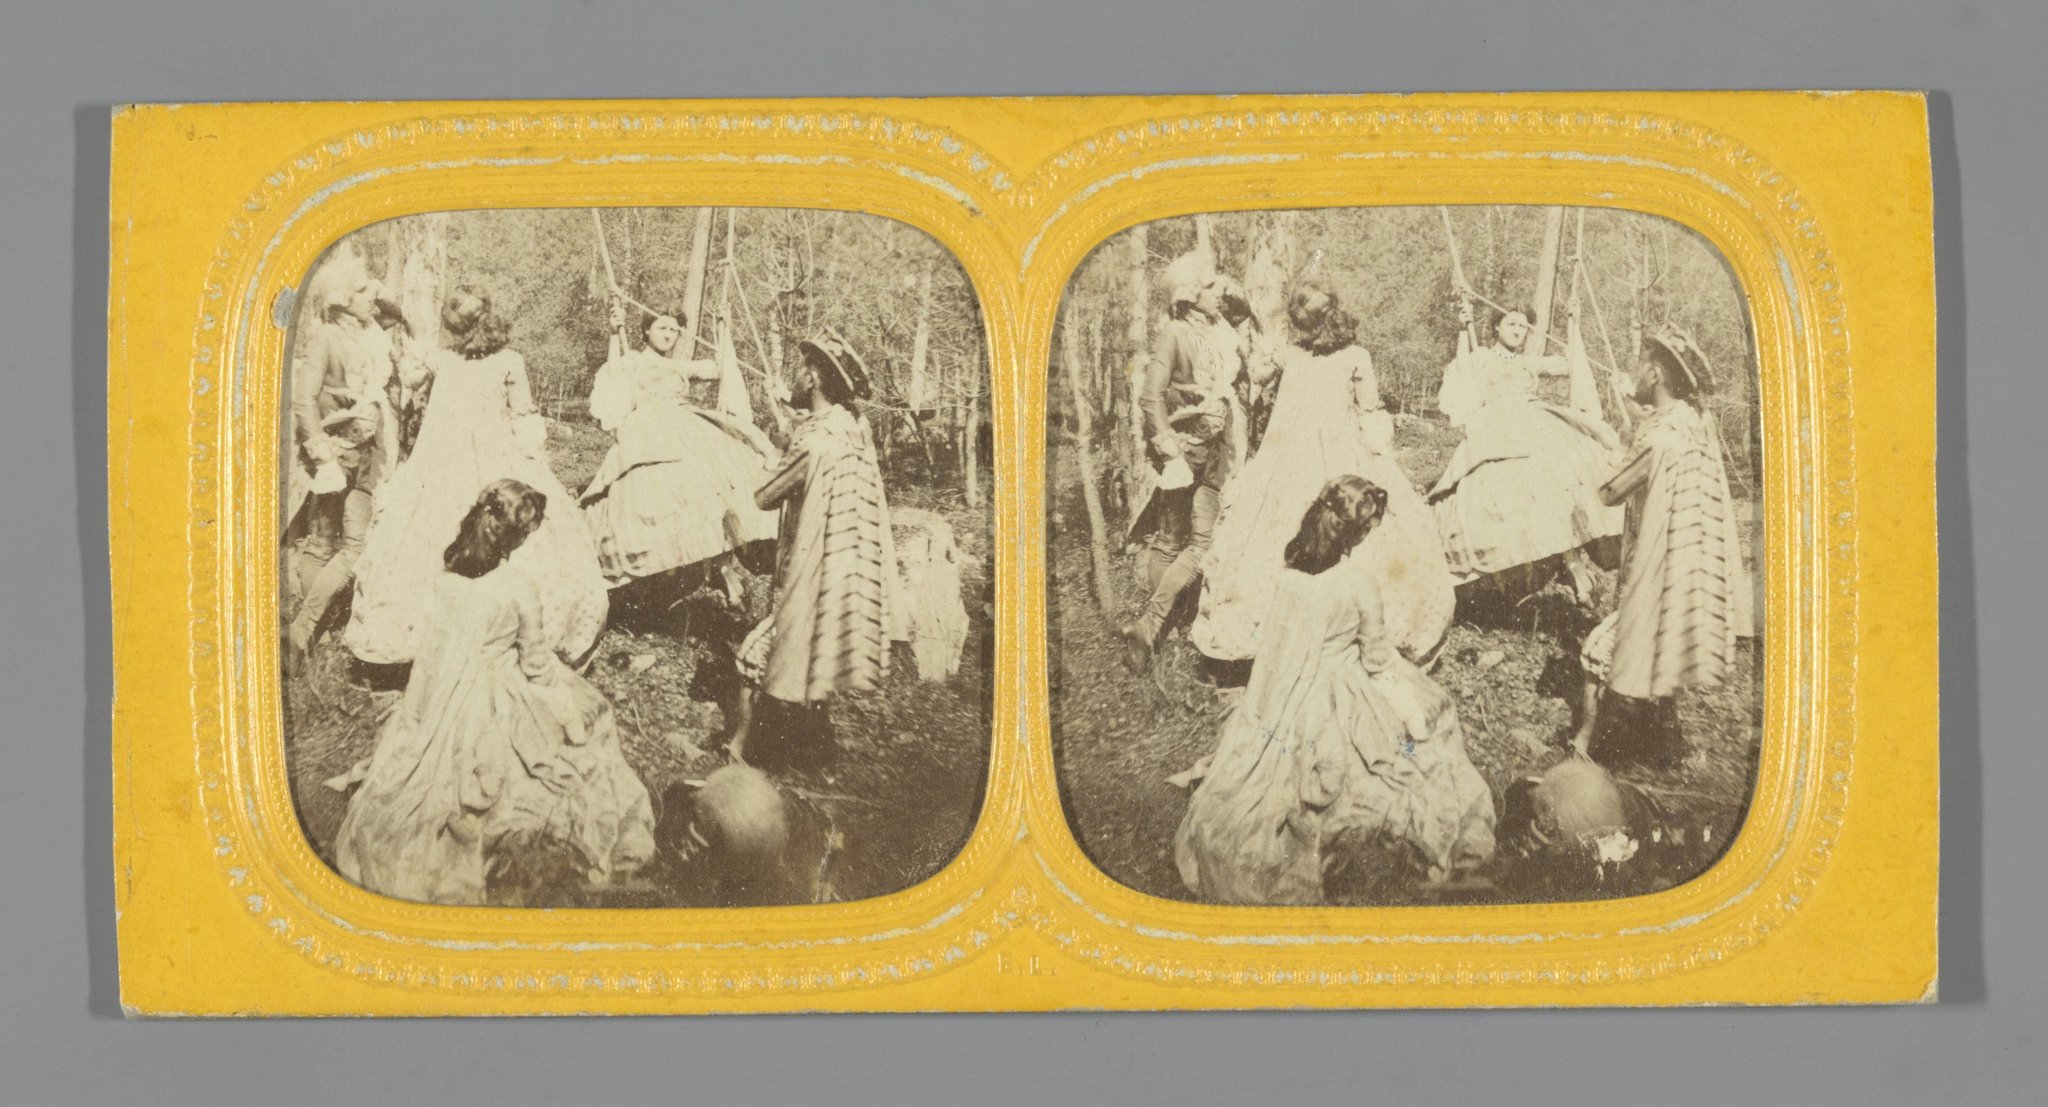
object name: tissue stereograph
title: Mensen verkleed als hovelingen van het hof van Lodewijk XV van Frankrijk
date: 1855-1875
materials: cardboard, paper, photographic support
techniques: albumen print, cutting, hand coloring, perforating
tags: swing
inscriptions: number: ‘40’, number: ‘No 11155/ 7 ox’